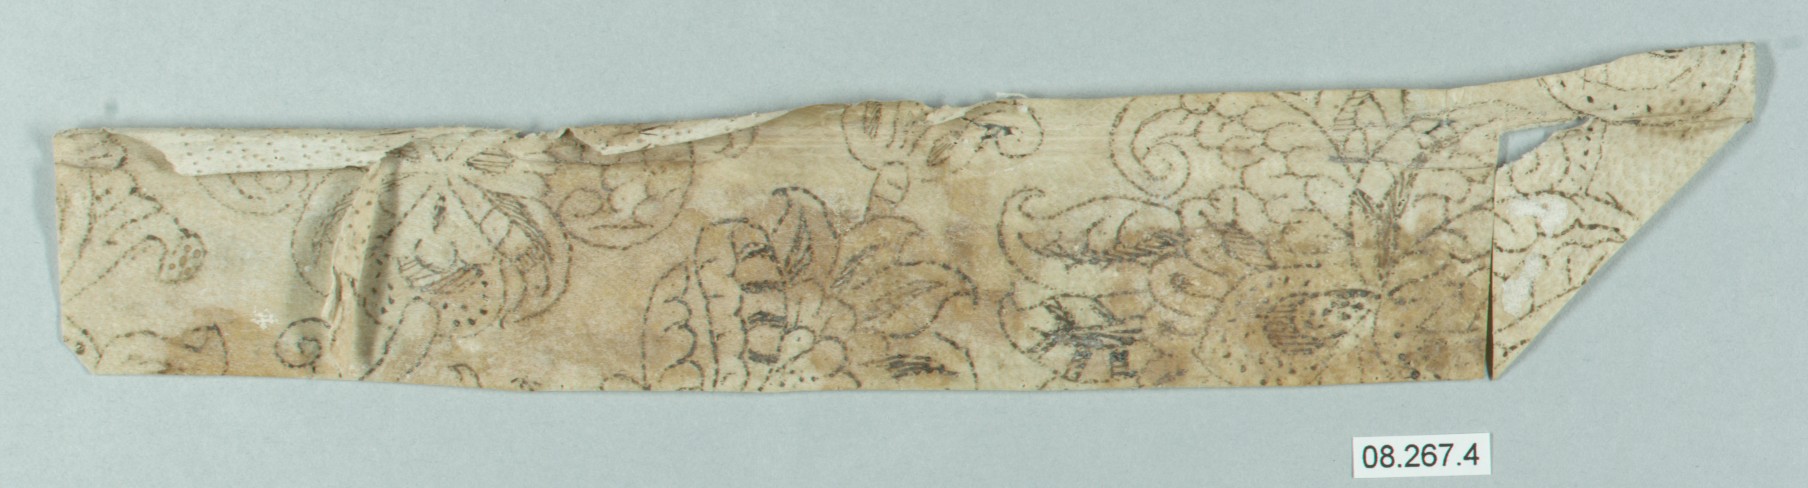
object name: pattern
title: Patterns (2)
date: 1701-1800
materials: parchment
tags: leaves